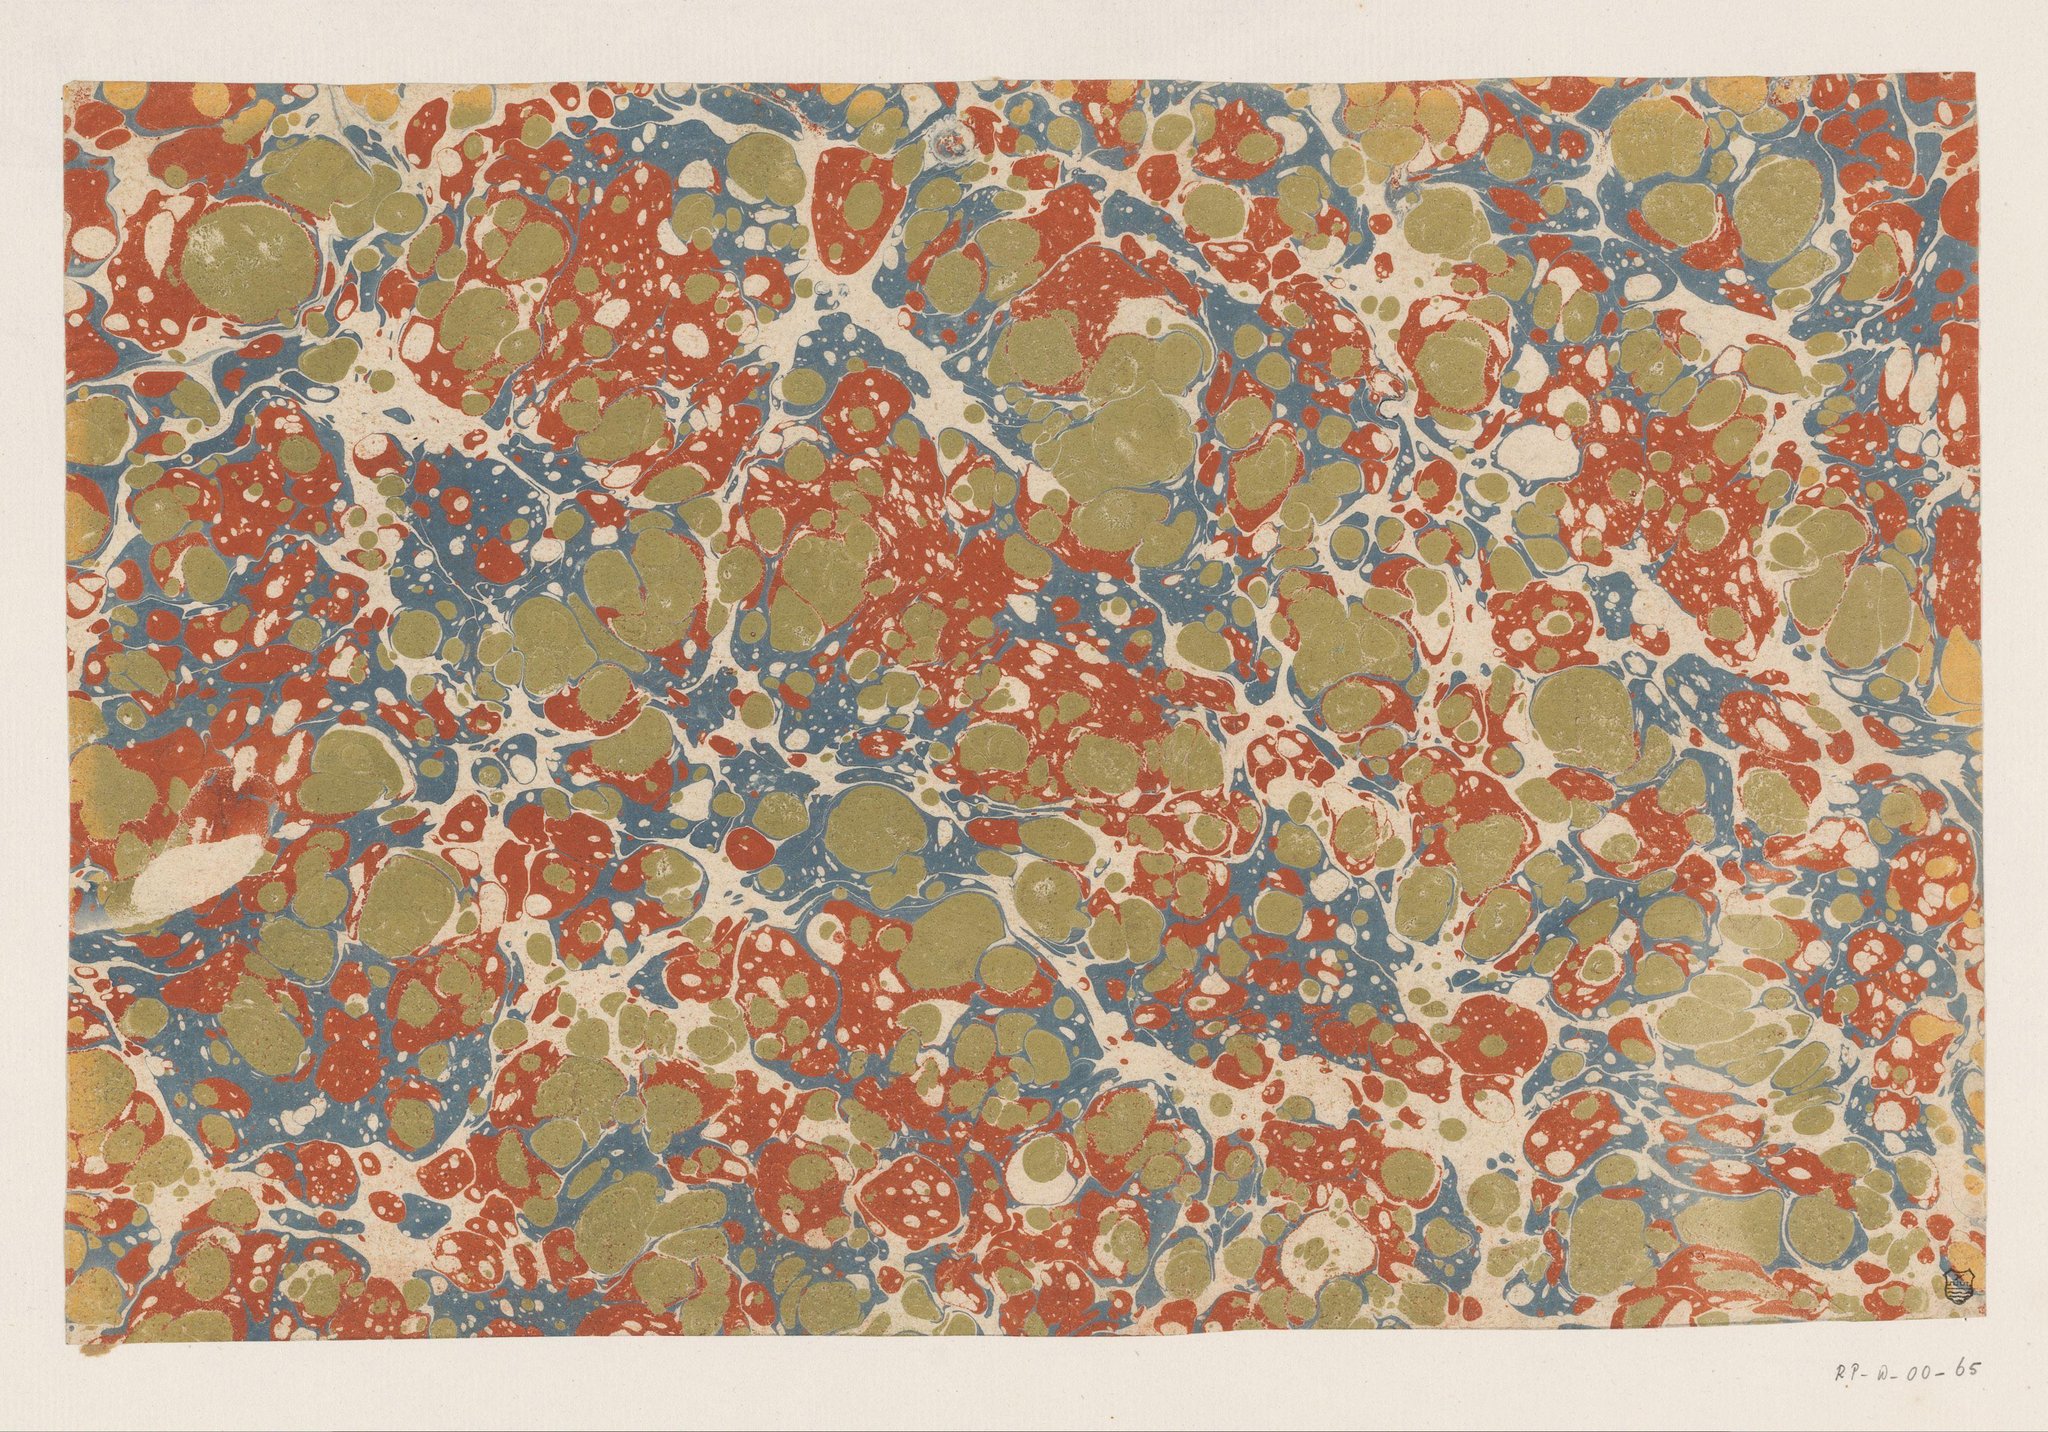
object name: marbled paper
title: Kiezelmarmer in blauw, rood en groen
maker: Anonymous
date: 1700-1850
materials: paint, paper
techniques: marbling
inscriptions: collector's mark: Lugt 2760